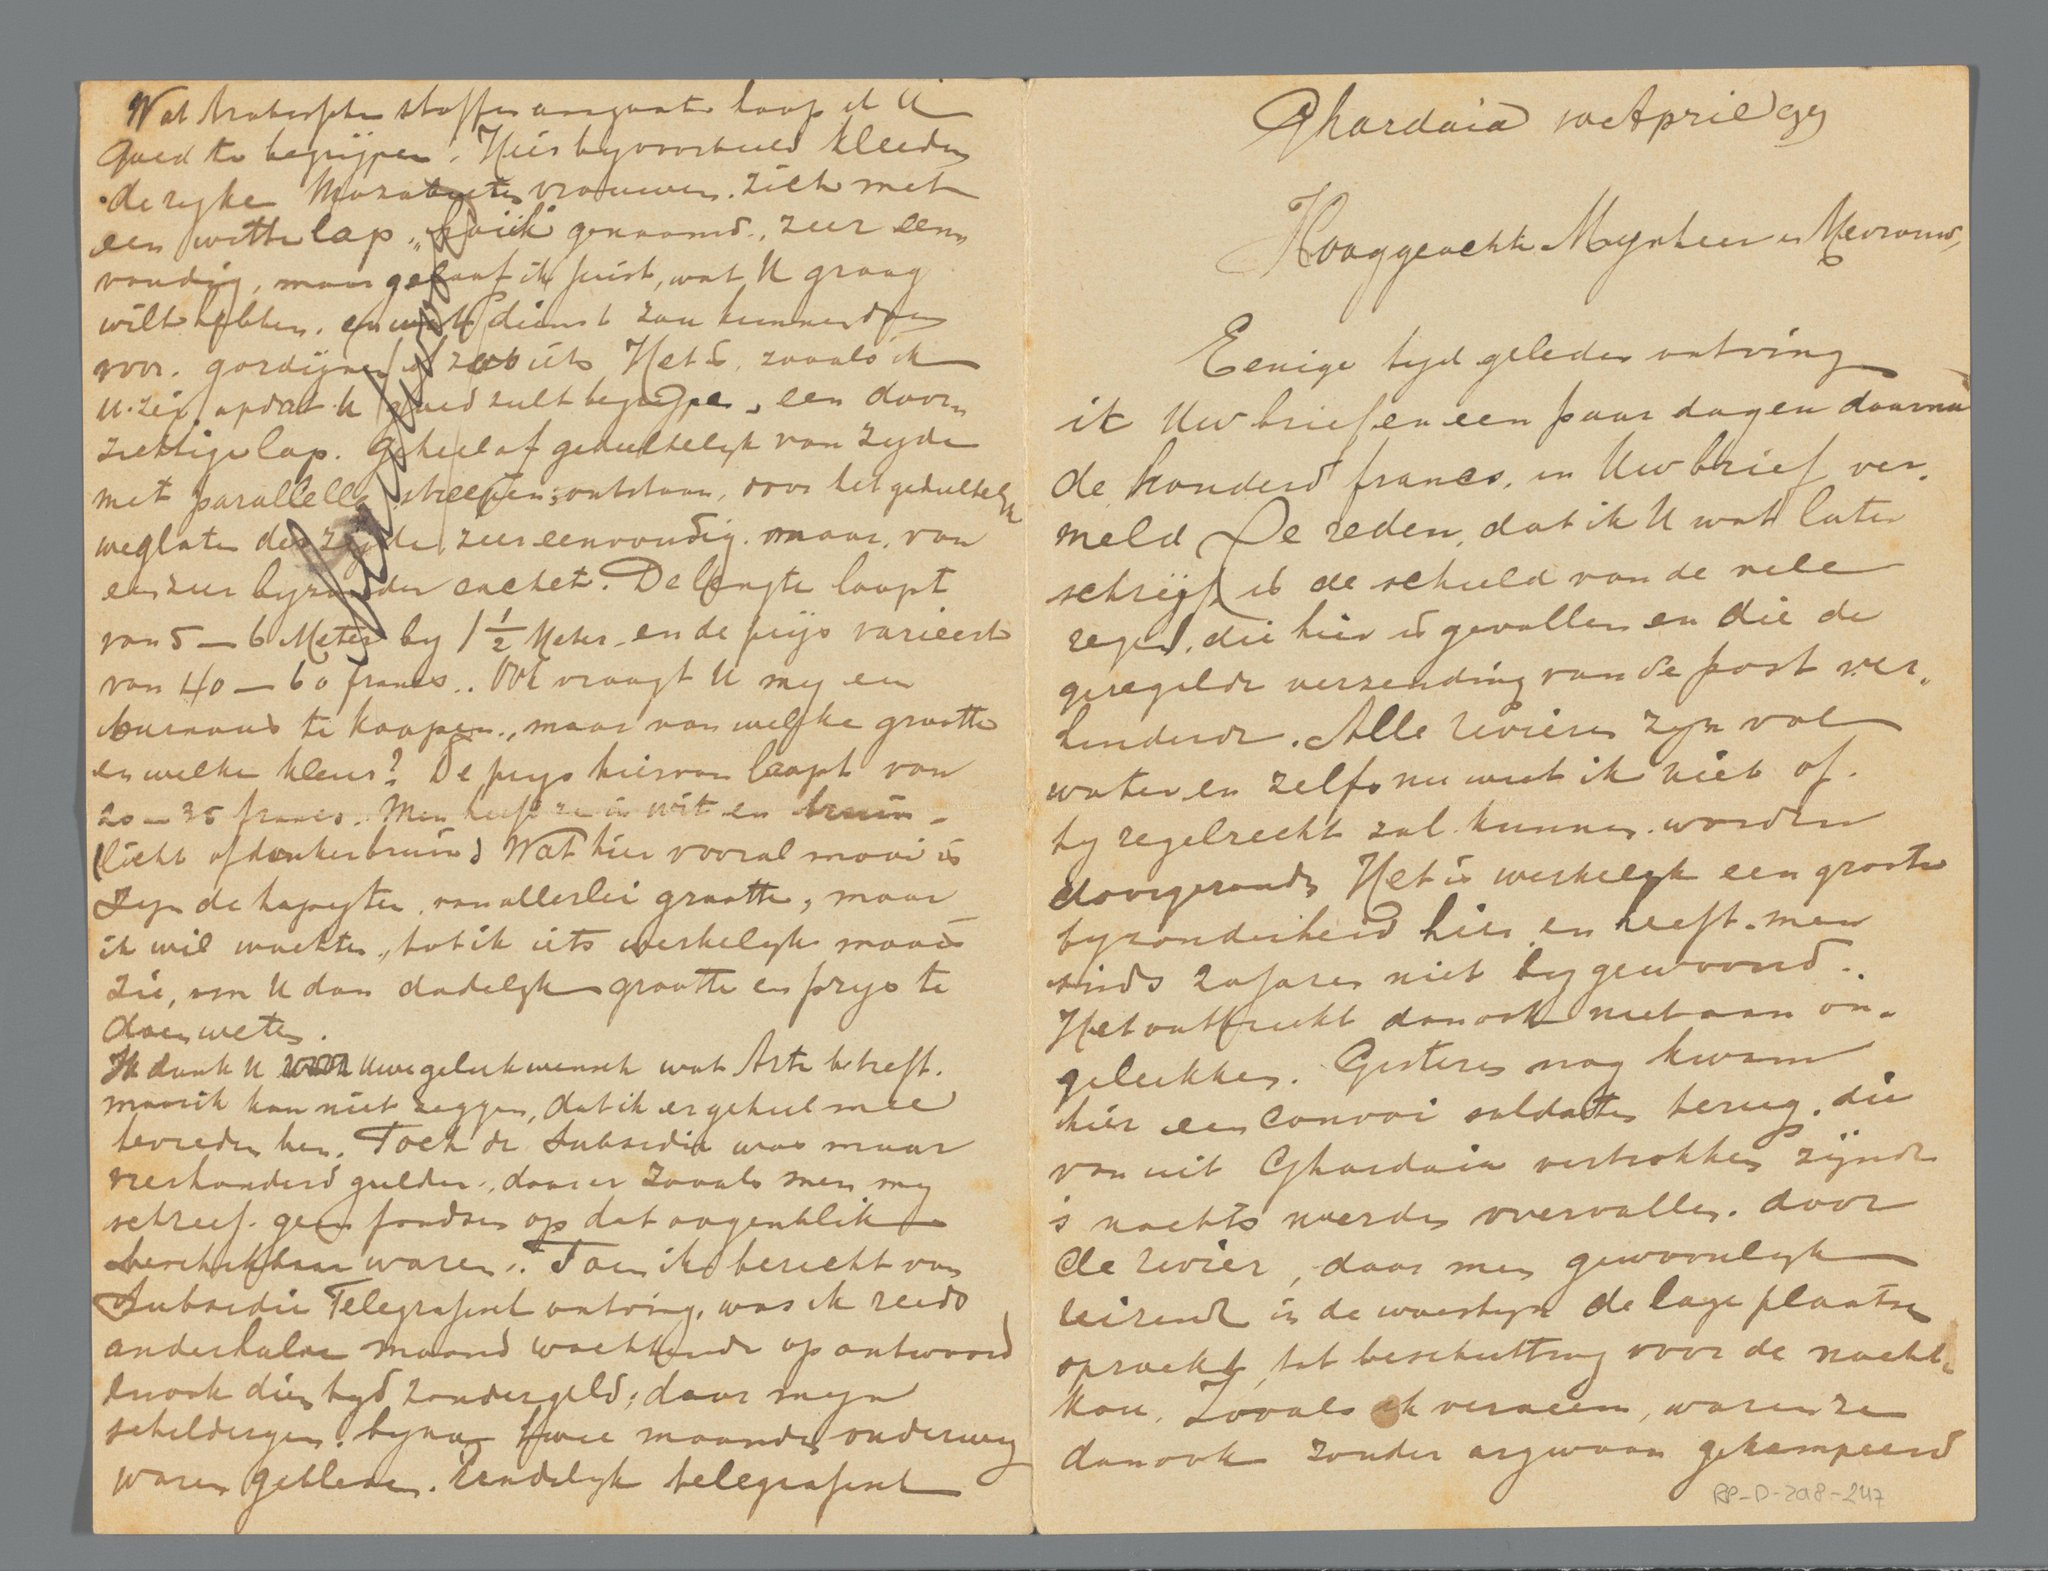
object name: letter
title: Brief aan Jeannette Bouman-Stuyling de Lange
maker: jac reijenga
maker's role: draughtsman, painter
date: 1893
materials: ink, paper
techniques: pen, writing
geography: algeria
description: Brief gericht aan mevrouw J. Bouman de Lange, Parkstraat, Alhier.